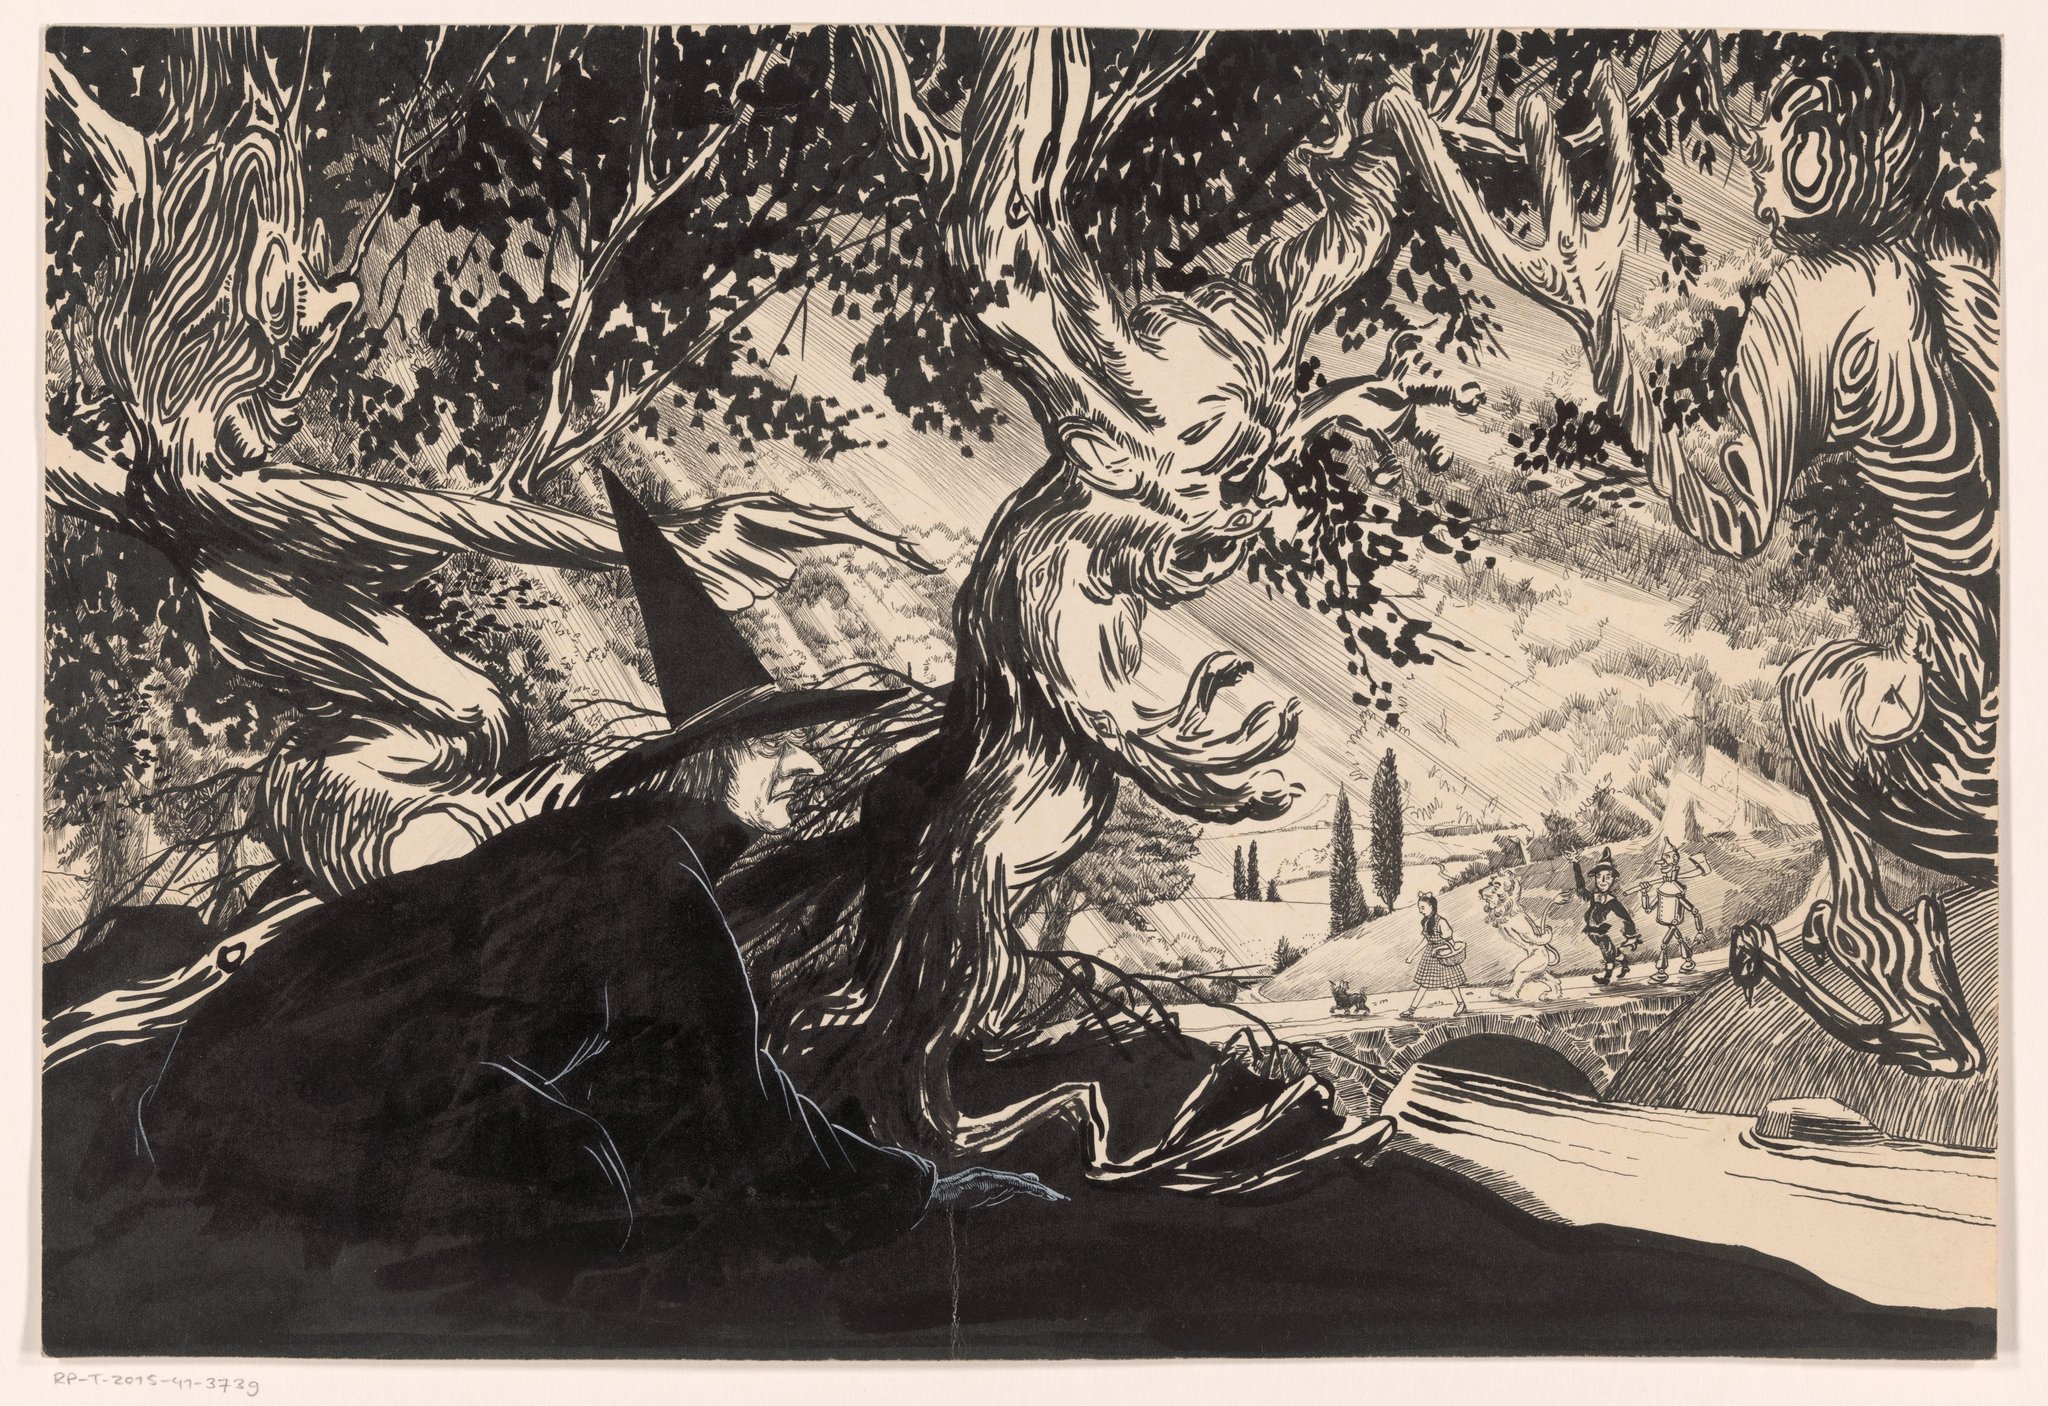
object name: drawing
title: Doortje en gezelschap steken een brug over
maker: rein van looy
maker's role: draughtsman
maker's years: 1910-1994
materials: paint, ink, paper, pencil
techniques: brush, pen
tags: witch, sorceress, anthropomorphic beings with parts of abnormal shape, bridge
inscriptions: :, collector's mark: Lugt 2228a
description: In een heuvellandschap steken Doortje en haar hond, de Laffe Leeuw, Vogelverschrikker en Blikken Man een brug over een rivier over. Aan de overzijde van de rivier kijkt de Boze heks van het Westen toe van achter de bomen, die uitvergrote menselijke gezichten en handen hebben.